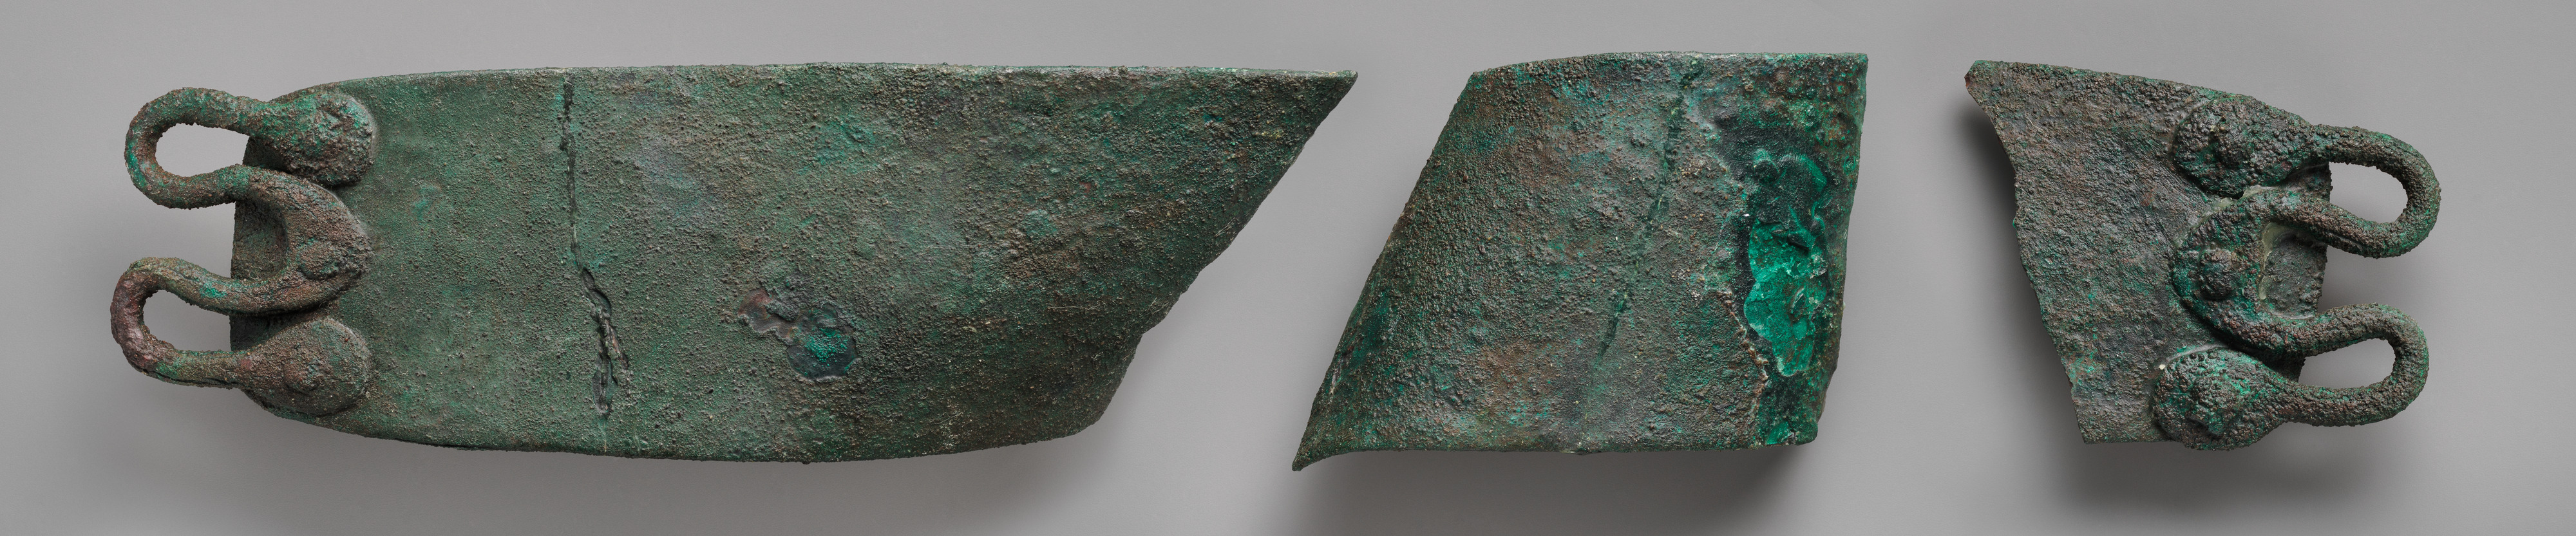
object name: belt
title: Belt fragment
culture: iranian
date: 900-801 BCE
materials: bronze, copper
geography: iran